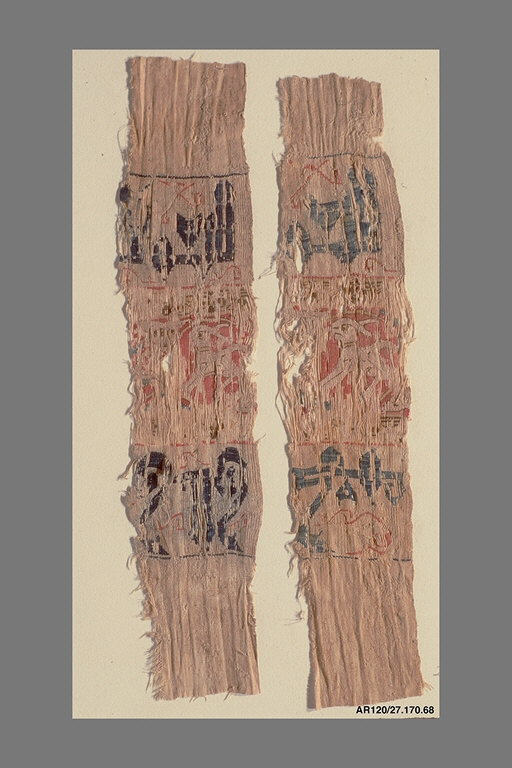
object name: textile fragment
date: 1001-1100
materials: linen, silk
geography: egypt